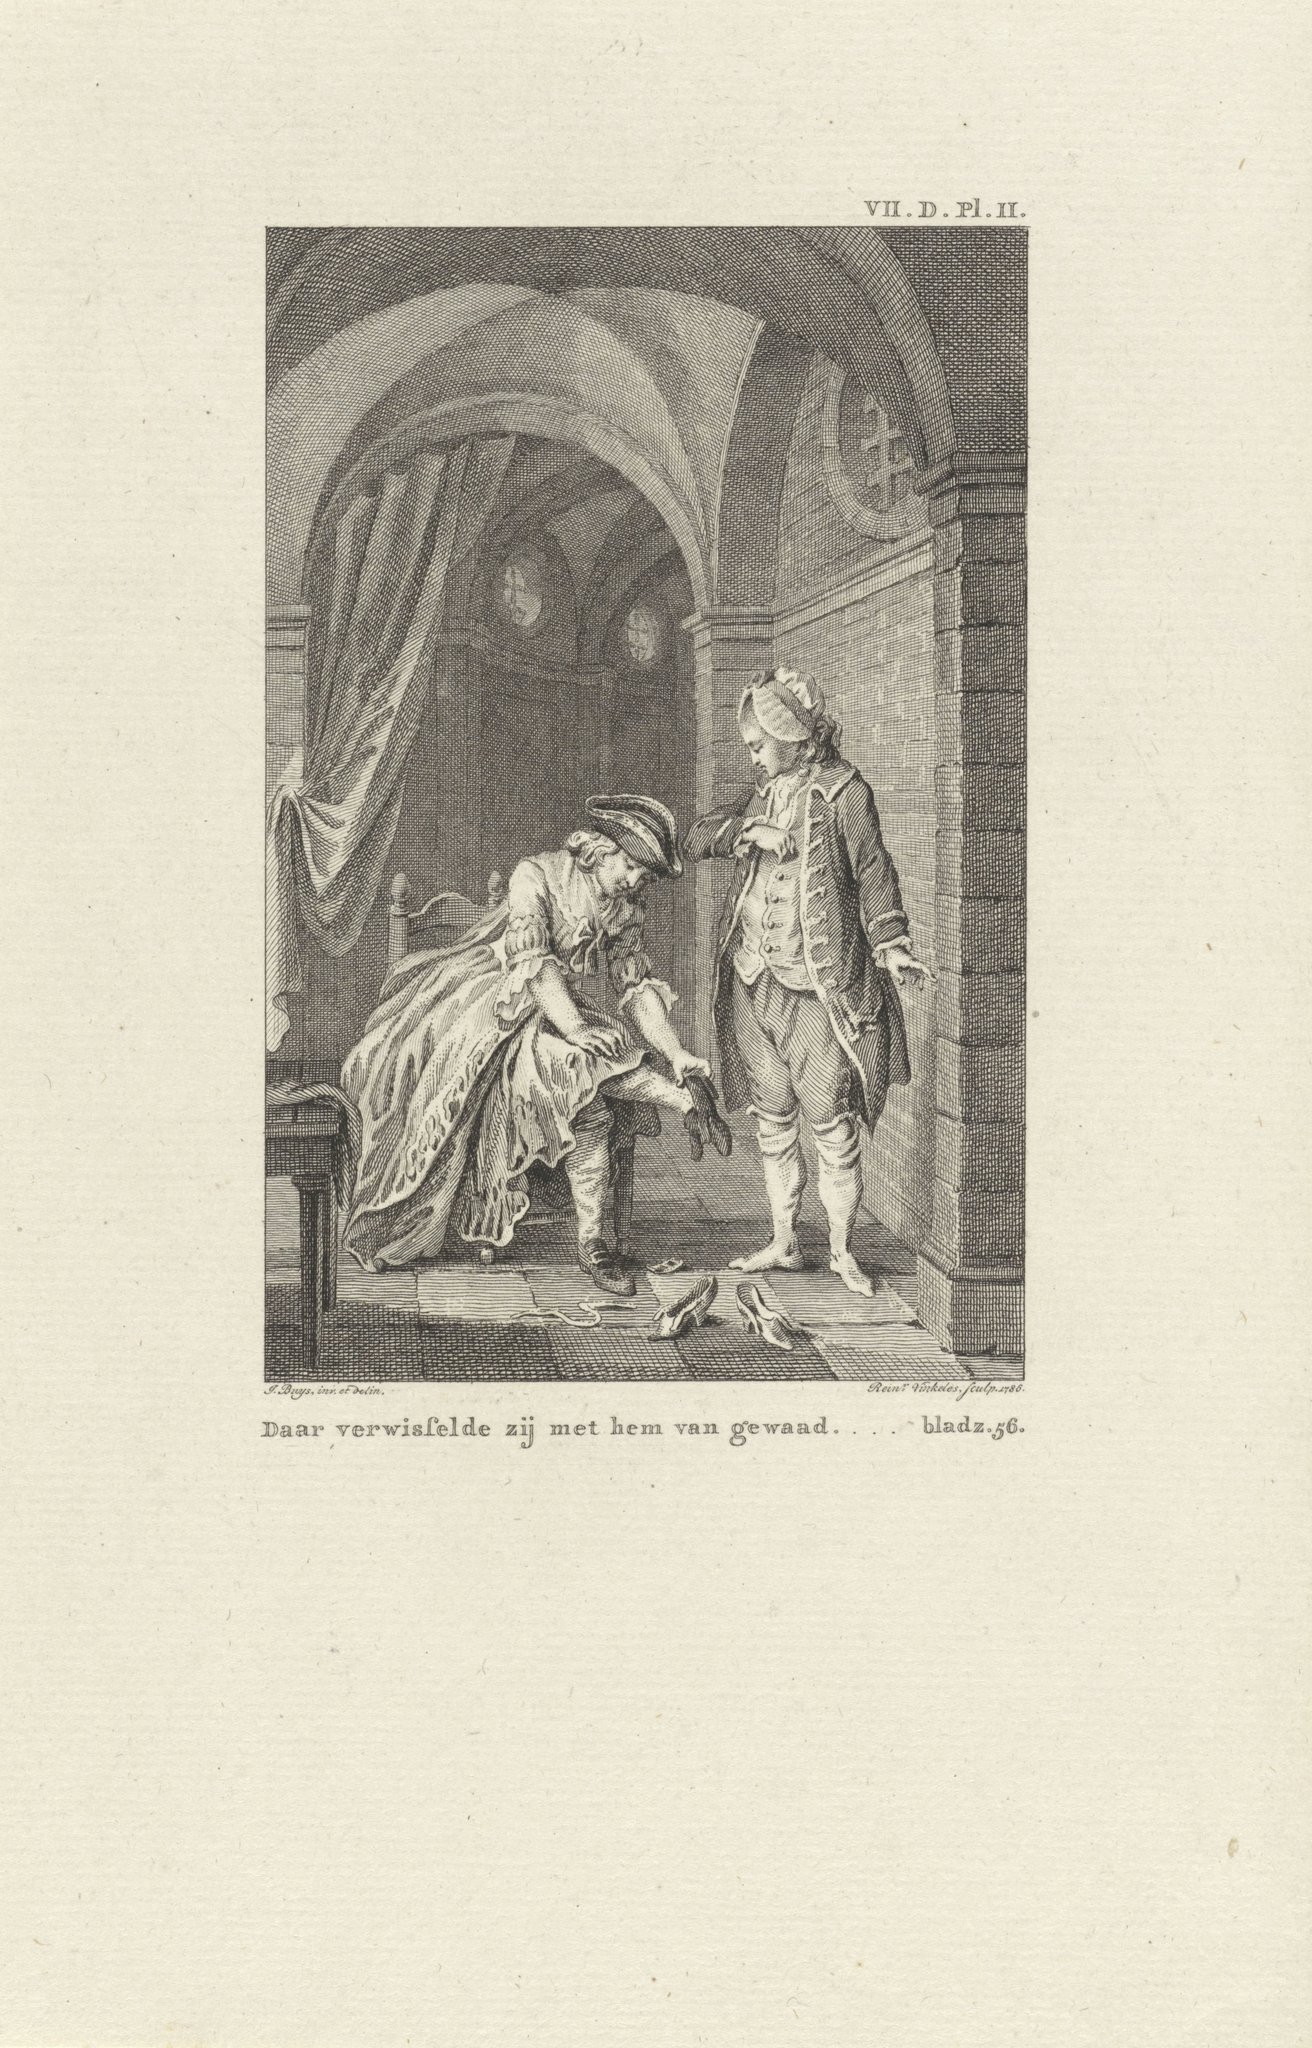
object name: book illustration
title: Daar verwisselde zij met hem van gewaad (...)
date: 1786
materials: paper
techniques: engraving, etching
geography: amsterdam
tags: earl, woman dressed as man, travesty, man dressed as woman, travesty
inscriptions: collector's mark: Lugt 240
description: William Maxwell, 5e graaf van Nithsdale verwisselt van kleding met zijn vrouw om te ontsnappen uit de gevangenis de Tower Green te Londen, nadat hij hier gevangen werd gezet na de opstand der Jacobieten in 1715. Rechtsboven: VII.D.Pl.II. Rechtsonder: Bladz.56.